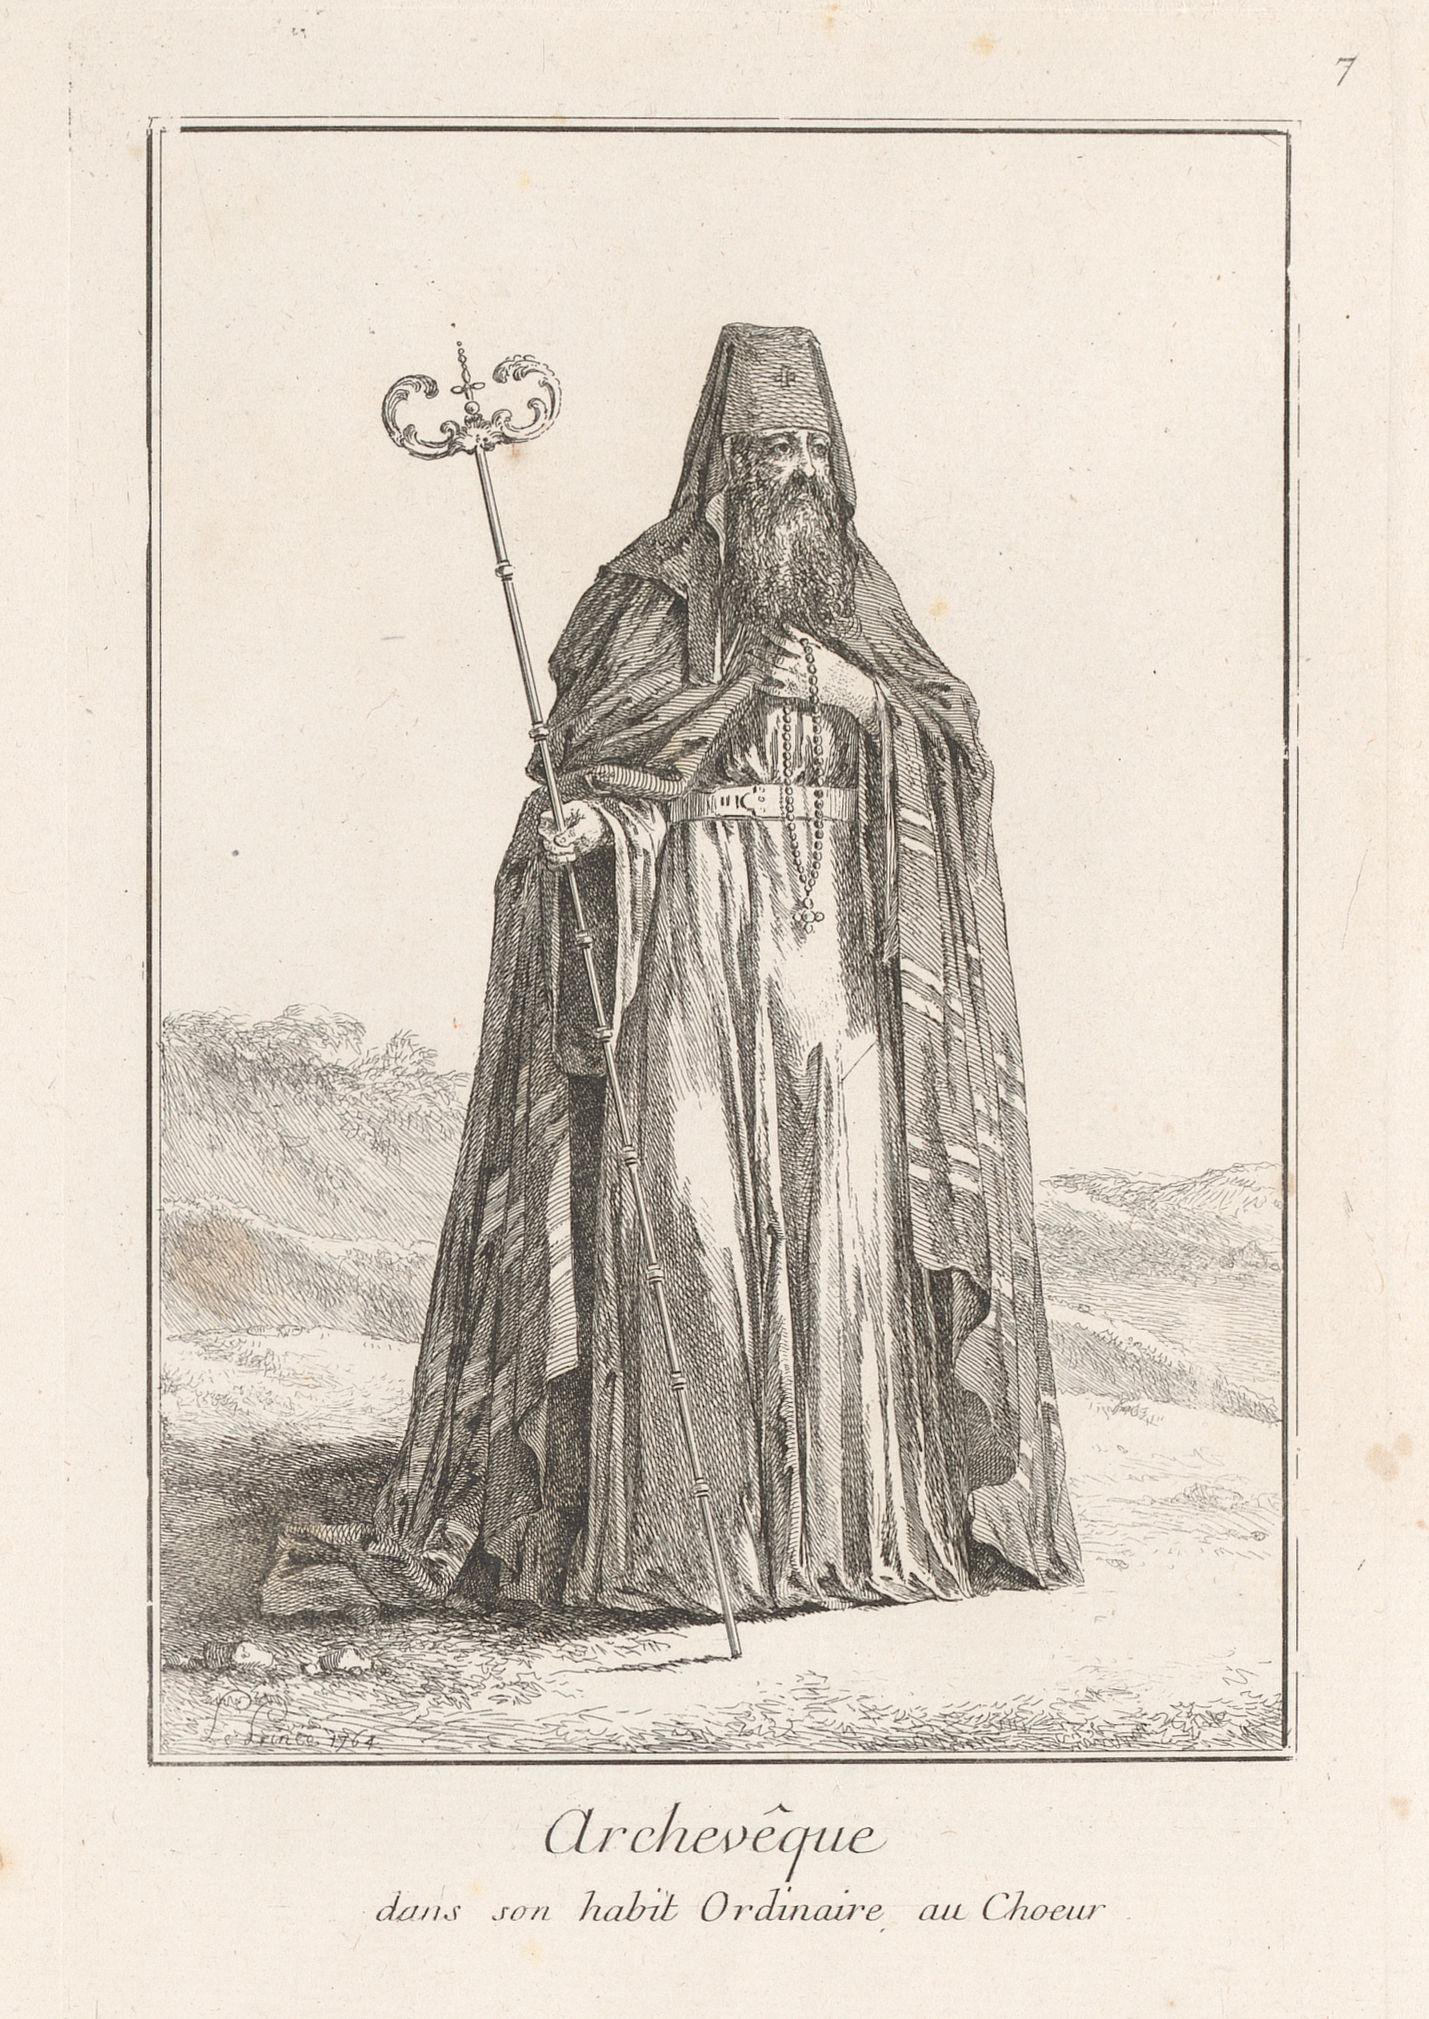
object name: album leaf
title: Archevêque dans son habit Ordinaire au Choeur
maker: jean baptist leprince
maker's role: draughtsman, print maker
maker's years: 1734-1781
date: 1764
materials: paper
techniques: etching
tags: russian orthodox church, archbishop, bishop, etc. (roman catholic)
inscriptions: date